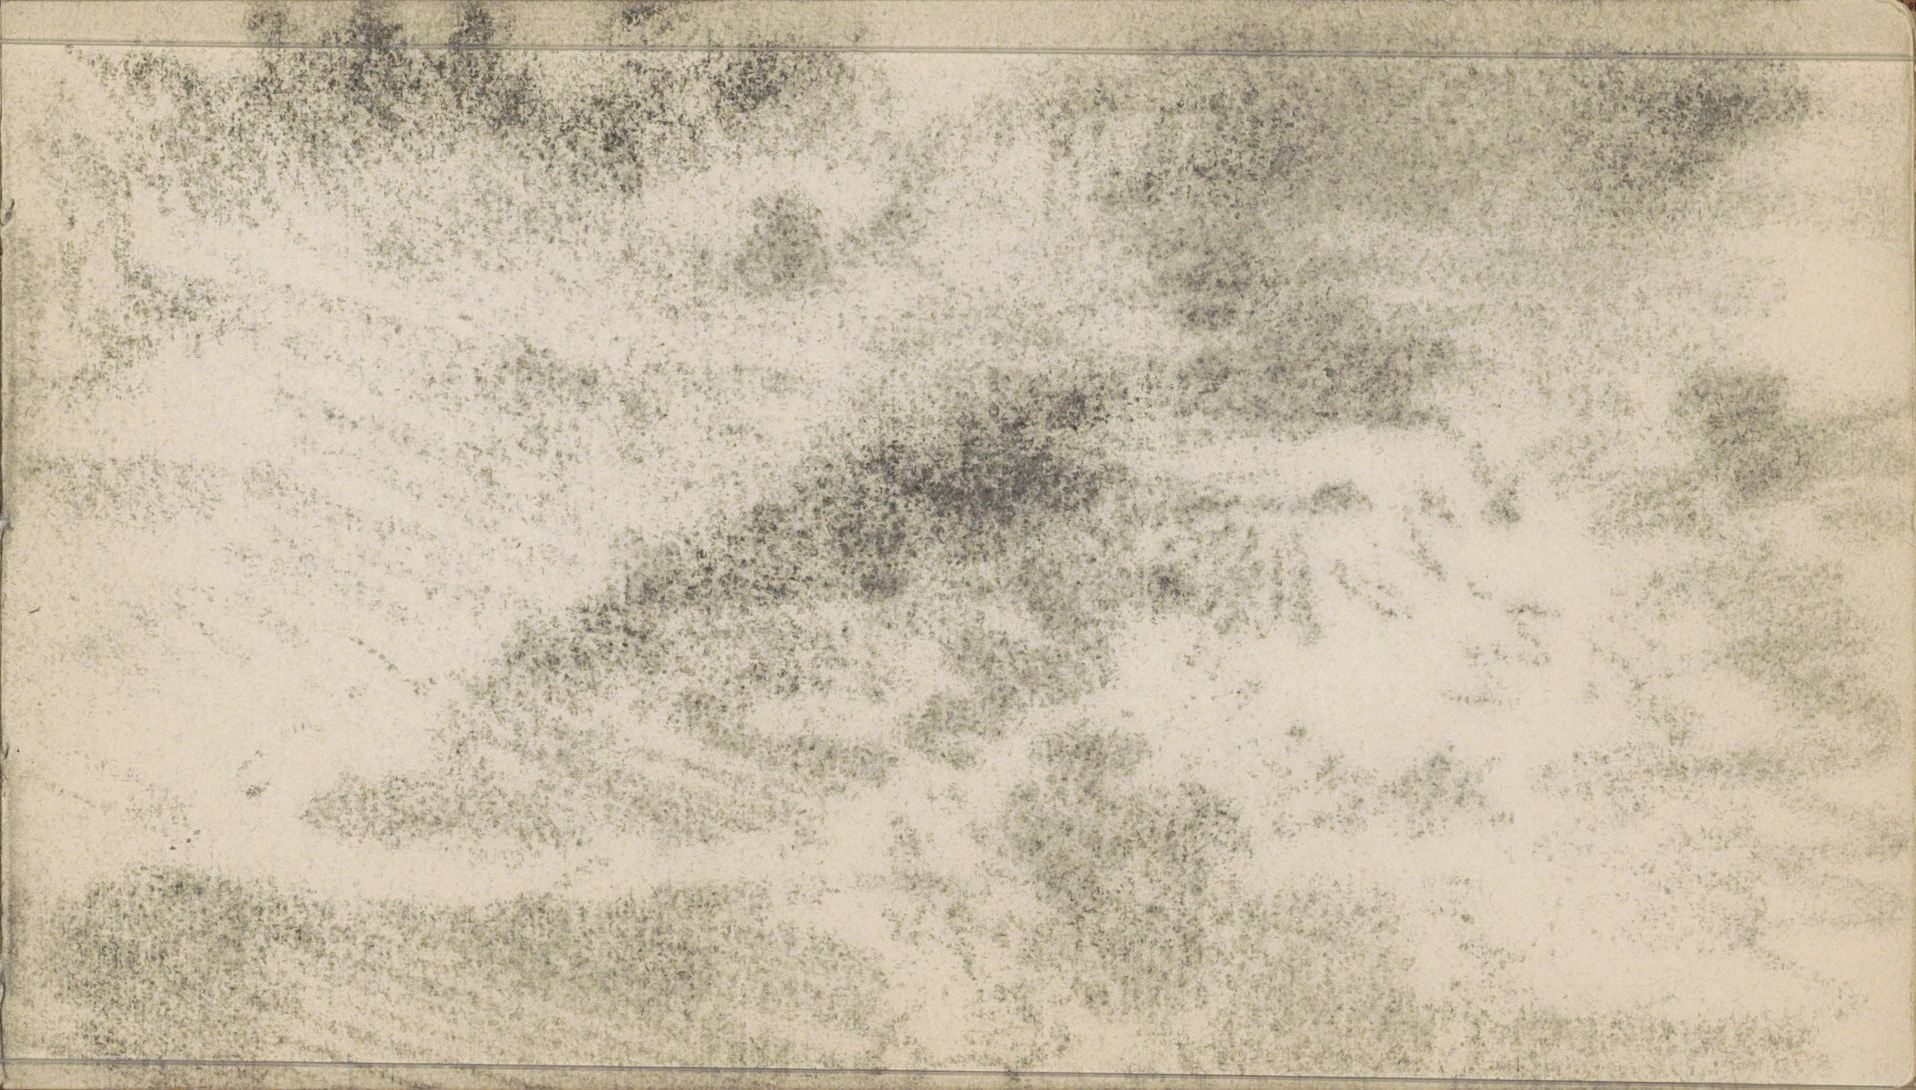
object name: sketchbook leaf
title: Abklatsch van de krijttekening op pagina 29 verso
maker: anton mauve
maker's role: draughtsman, painter, print maker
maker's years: 1838-1888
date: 1876-1879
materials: paper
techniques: printmaking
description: Blad 30 recto uit een schetsboek met 33 bladen.